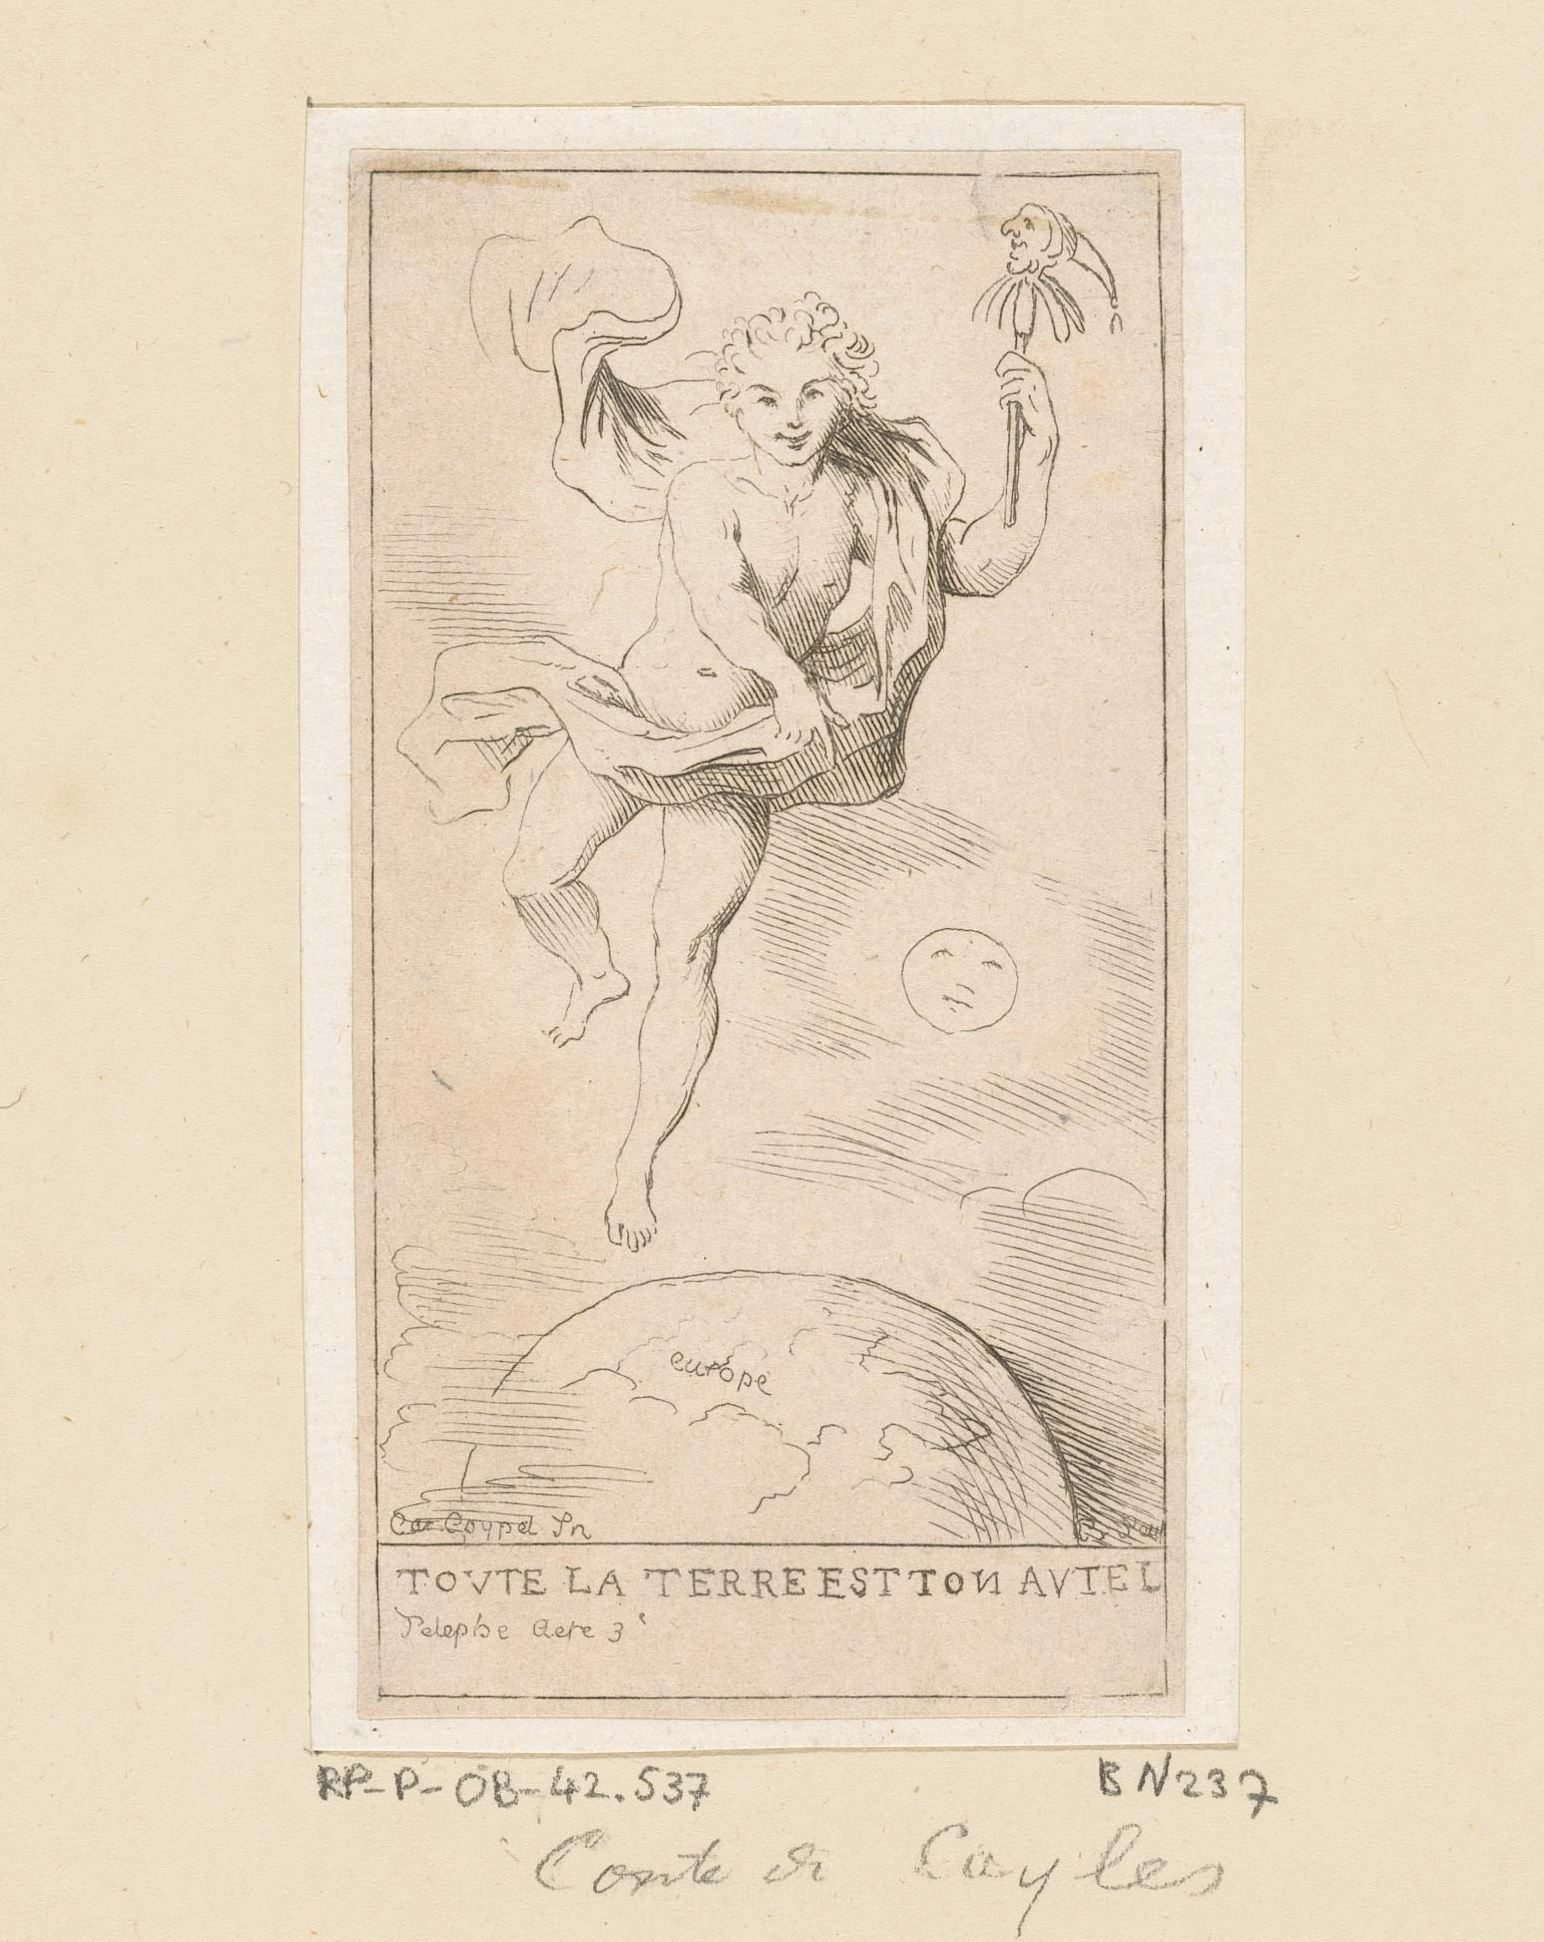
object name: print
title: Amor met een zotskop in de hand boven een wereldbol zwevend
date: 1702-1765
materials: paper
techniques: etching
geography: france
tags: earth, world as celestial body, (story of) cupid, amor (eros)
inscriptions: collector's mark: Lugt 240